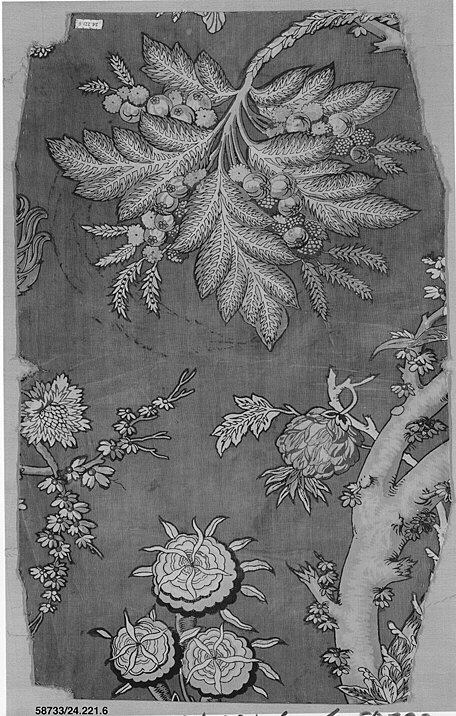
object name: piece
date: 1840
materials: linen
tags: fruit,flowers,leaves